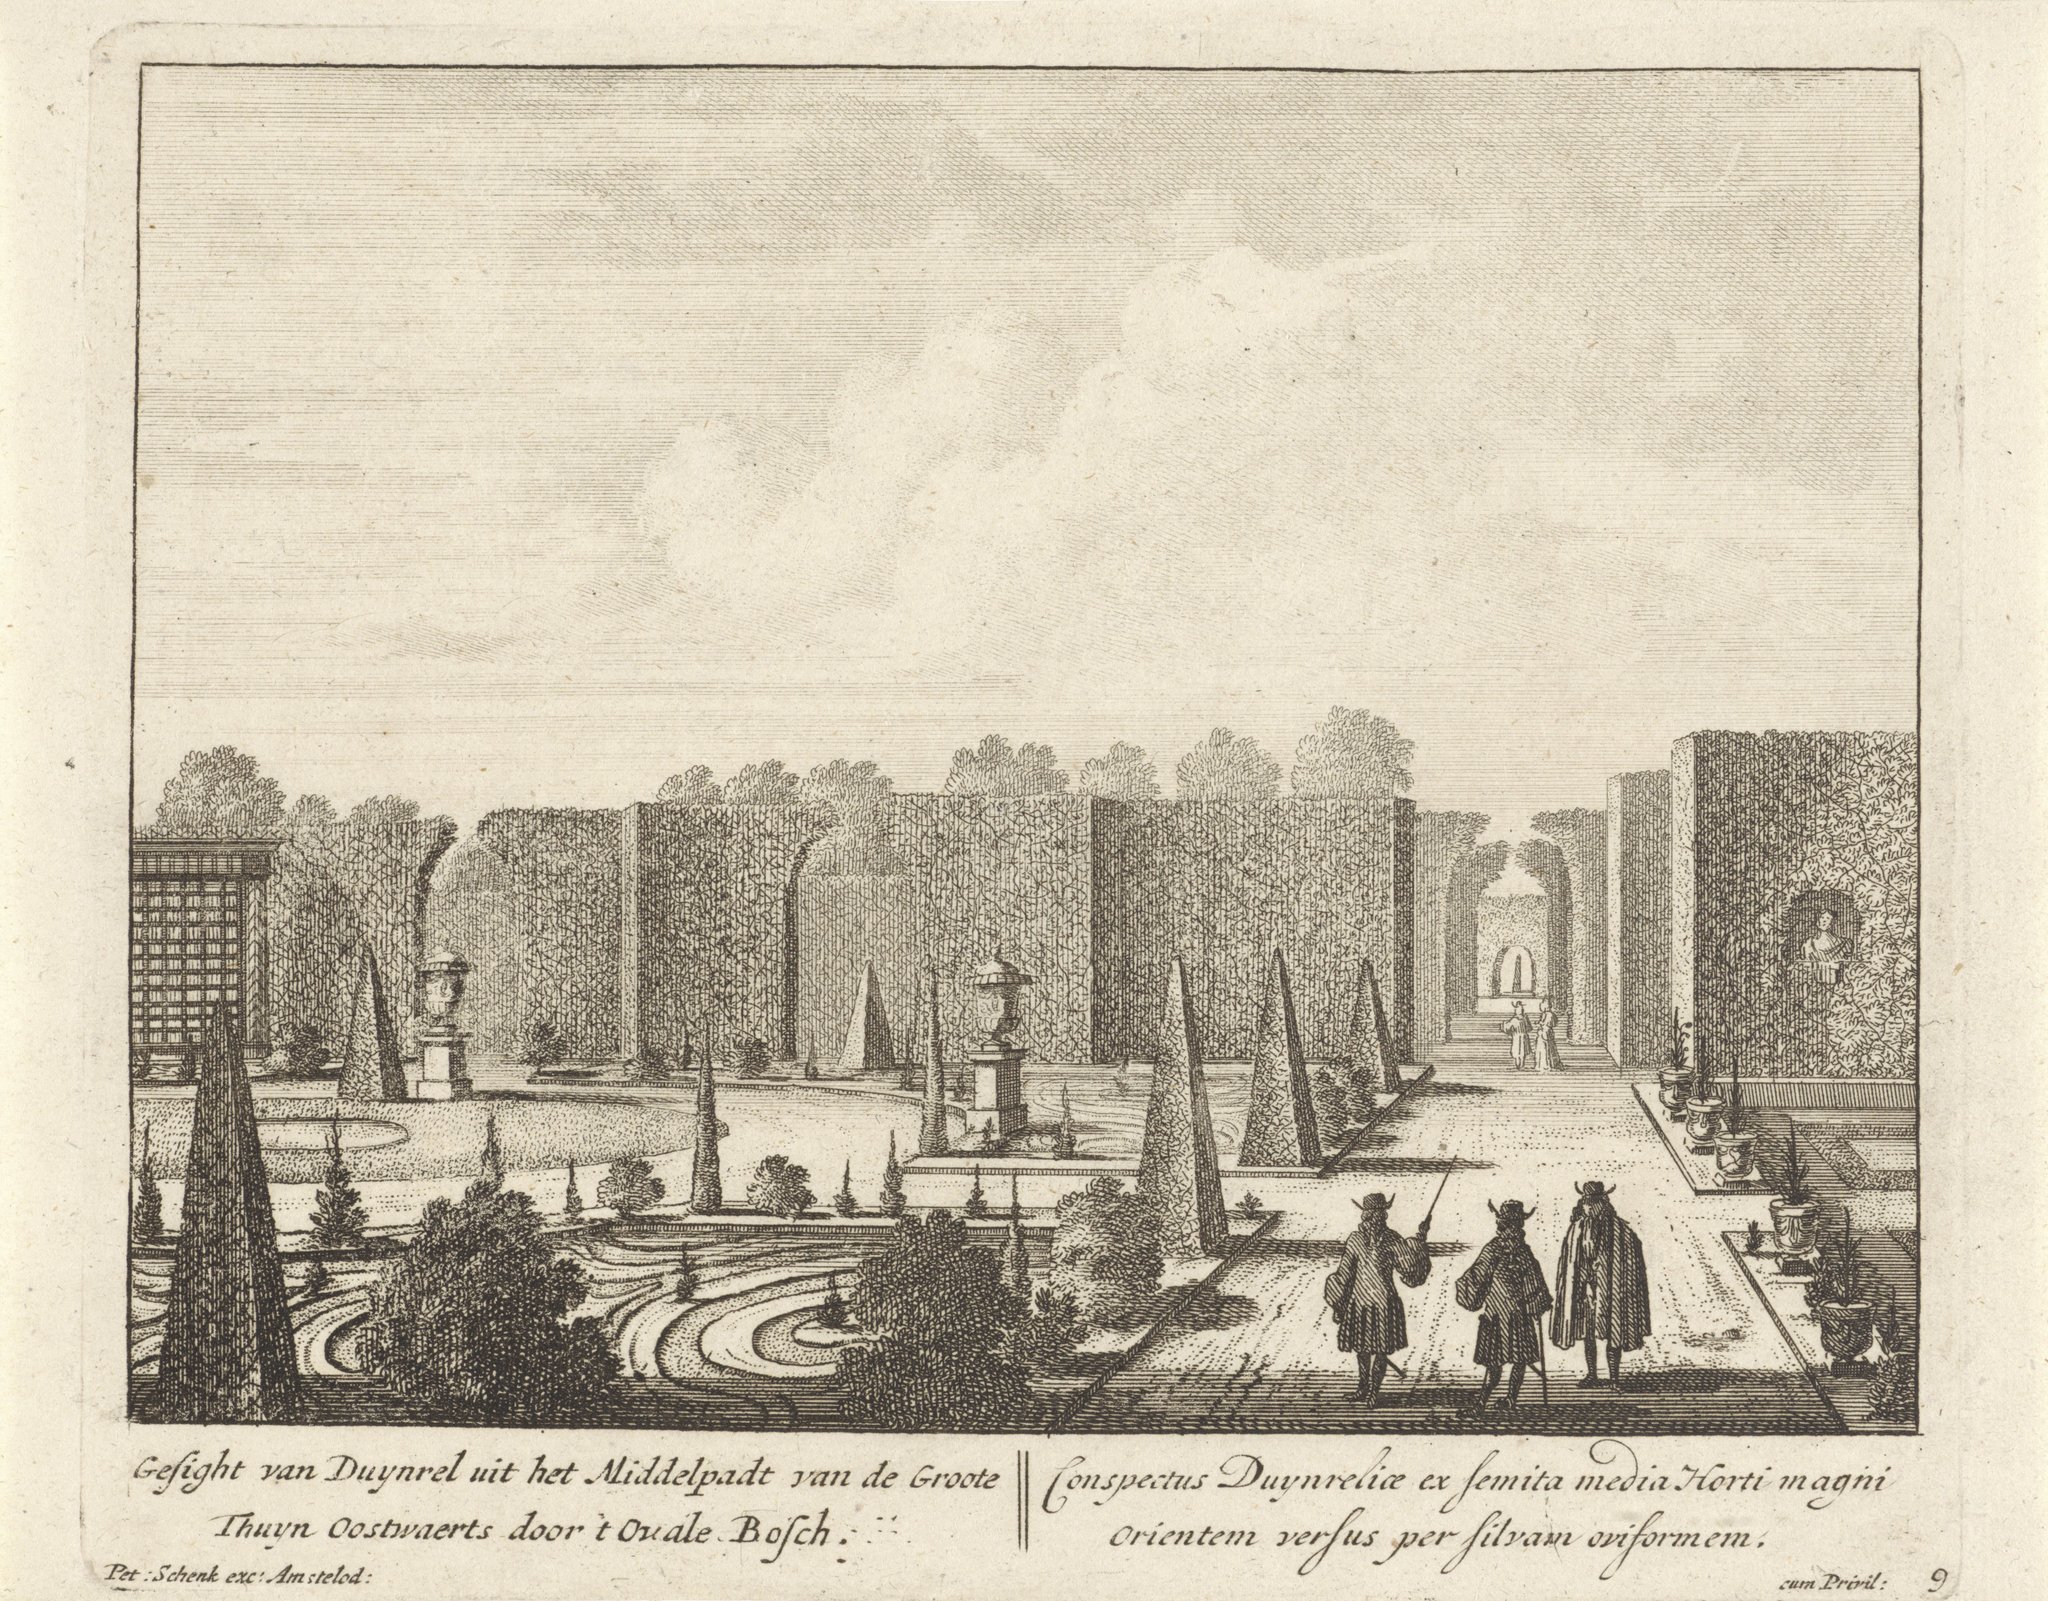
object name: print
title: Gesight van Duynrel in het middelpadt van de groote thuyn oostwaerts door 't ovale bosch / Conspectus Duynreliae ex femita media horti magni orientem versus per silvam oviformem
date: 1675-1711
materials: paper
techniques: engraving, etching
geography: amsterdam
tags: french or architectonic garden; formal garden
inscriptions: collector's mark: Lugt 2228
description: Gezicht op het ovale bos in de tuin van buitenplaats Duinrell, gezien richting het oosten. Rechts op het middenpad van de tuin enkele figuren. Rechtsonder genummerd: 9. Prent uit een serie van zestien prenten van Duinrell.